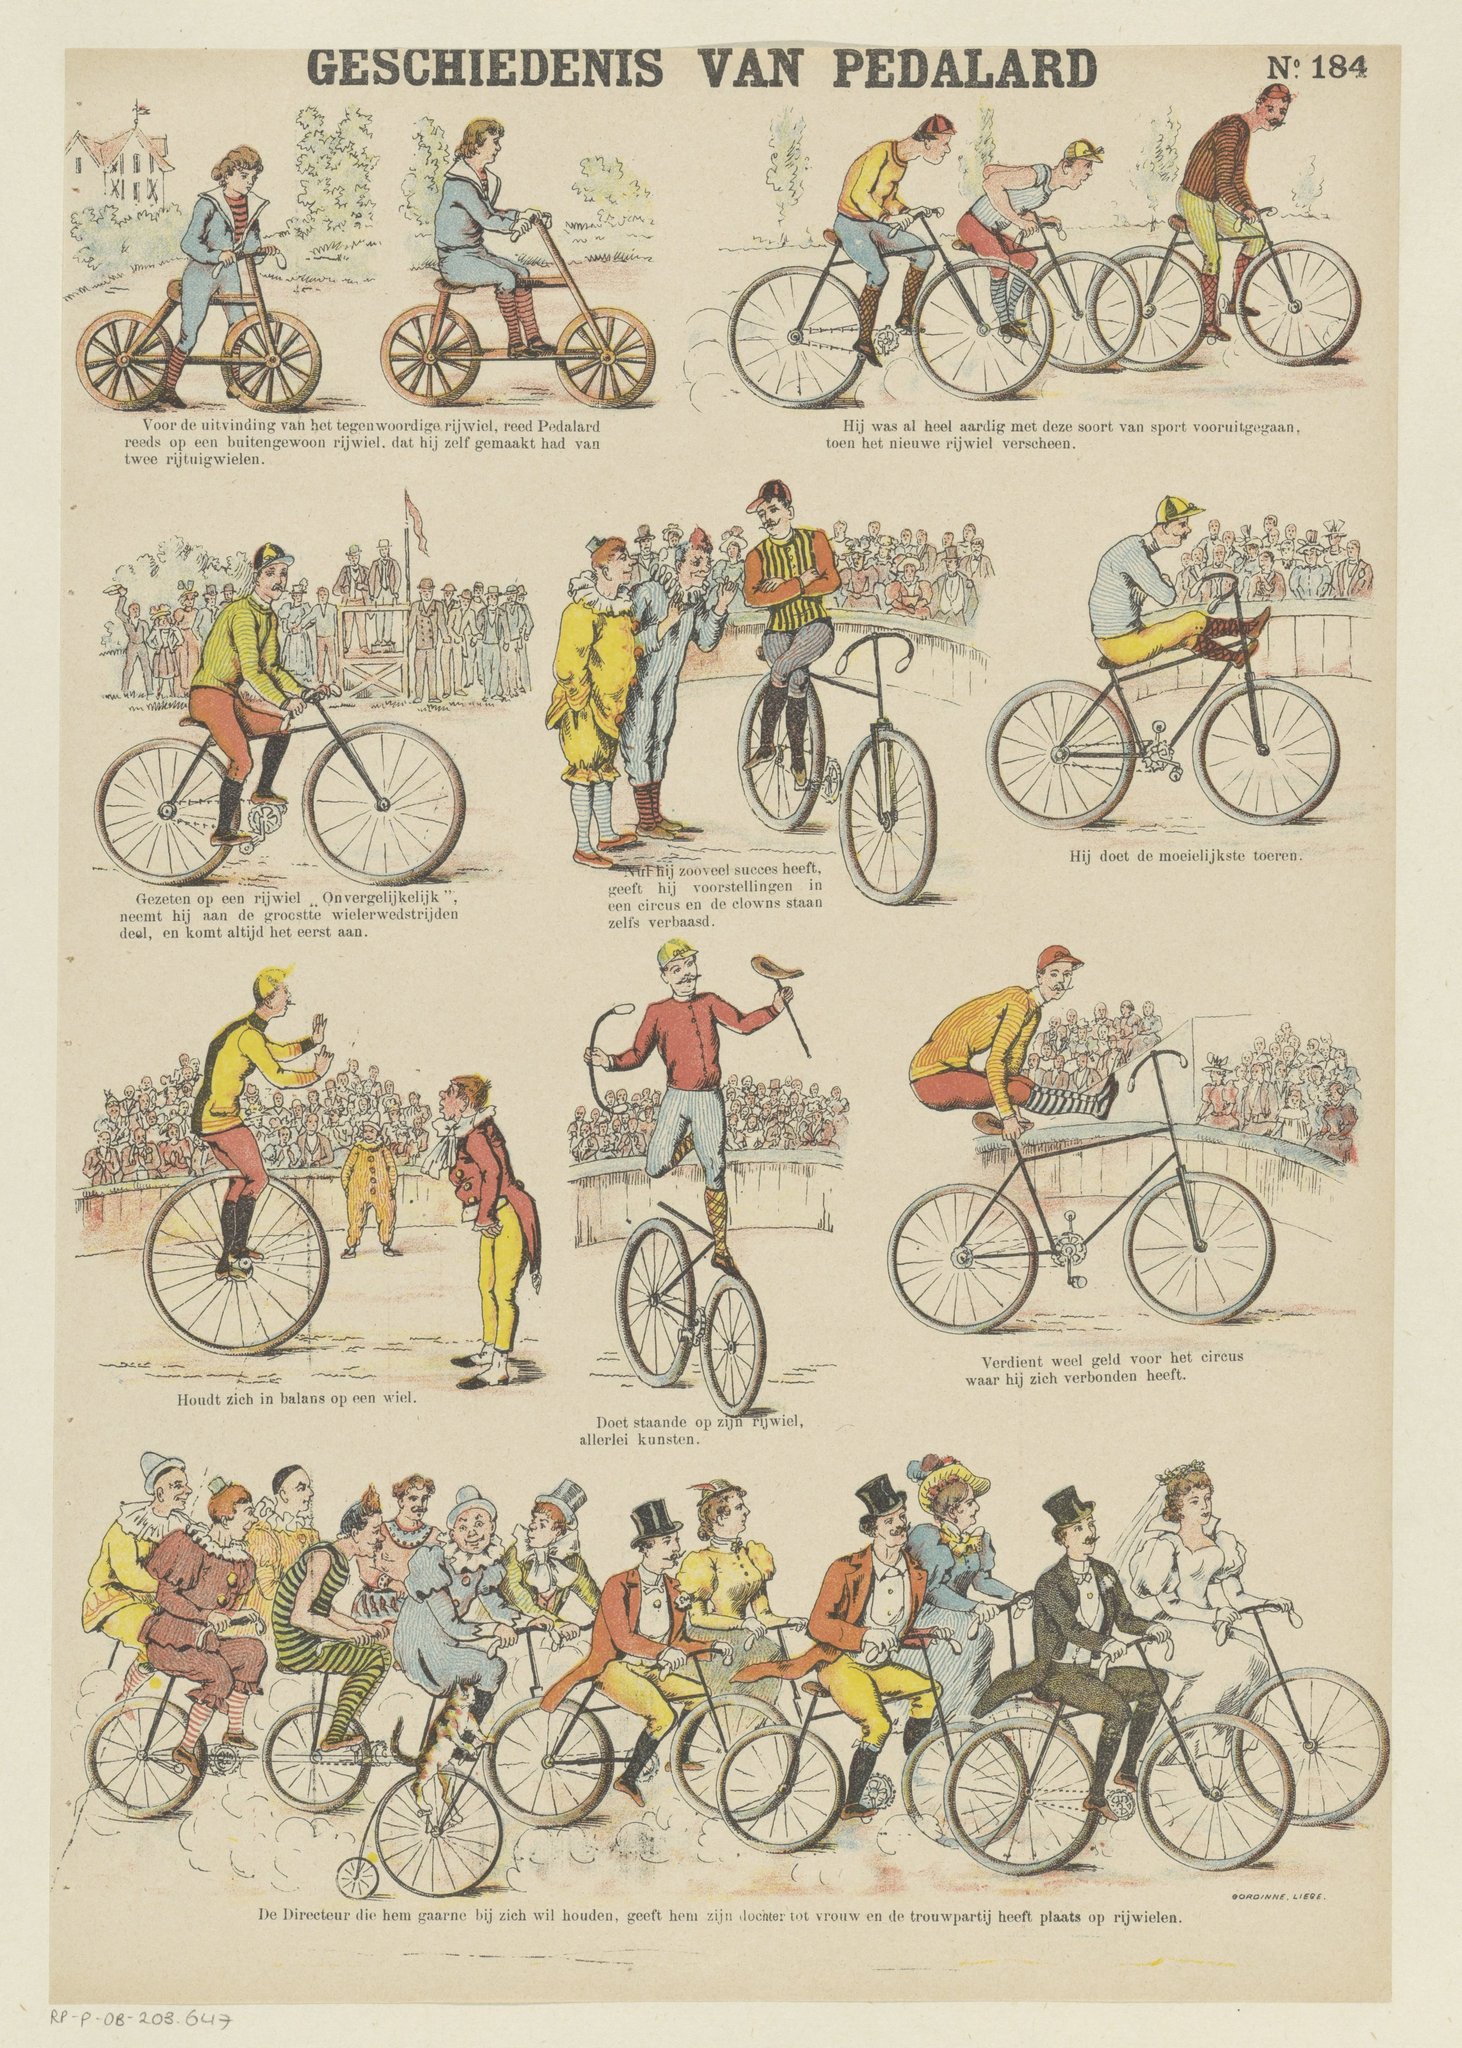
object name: print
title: Geschiedenis van Pedalard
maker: Anonymous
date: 1894-1959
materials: paper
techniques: lithograph, letterpress printing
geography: liège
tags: circus, bicycle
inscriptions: collector's mark: Lugt 2760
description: Blad met 10 voorstellingen over het leven van Pedalard die heel goed kan fietsen en trouwt met de dochter van de circusdirecteur. Onder elke afbeelding een onderschrift. Genummerd rechtsboven: No 184.